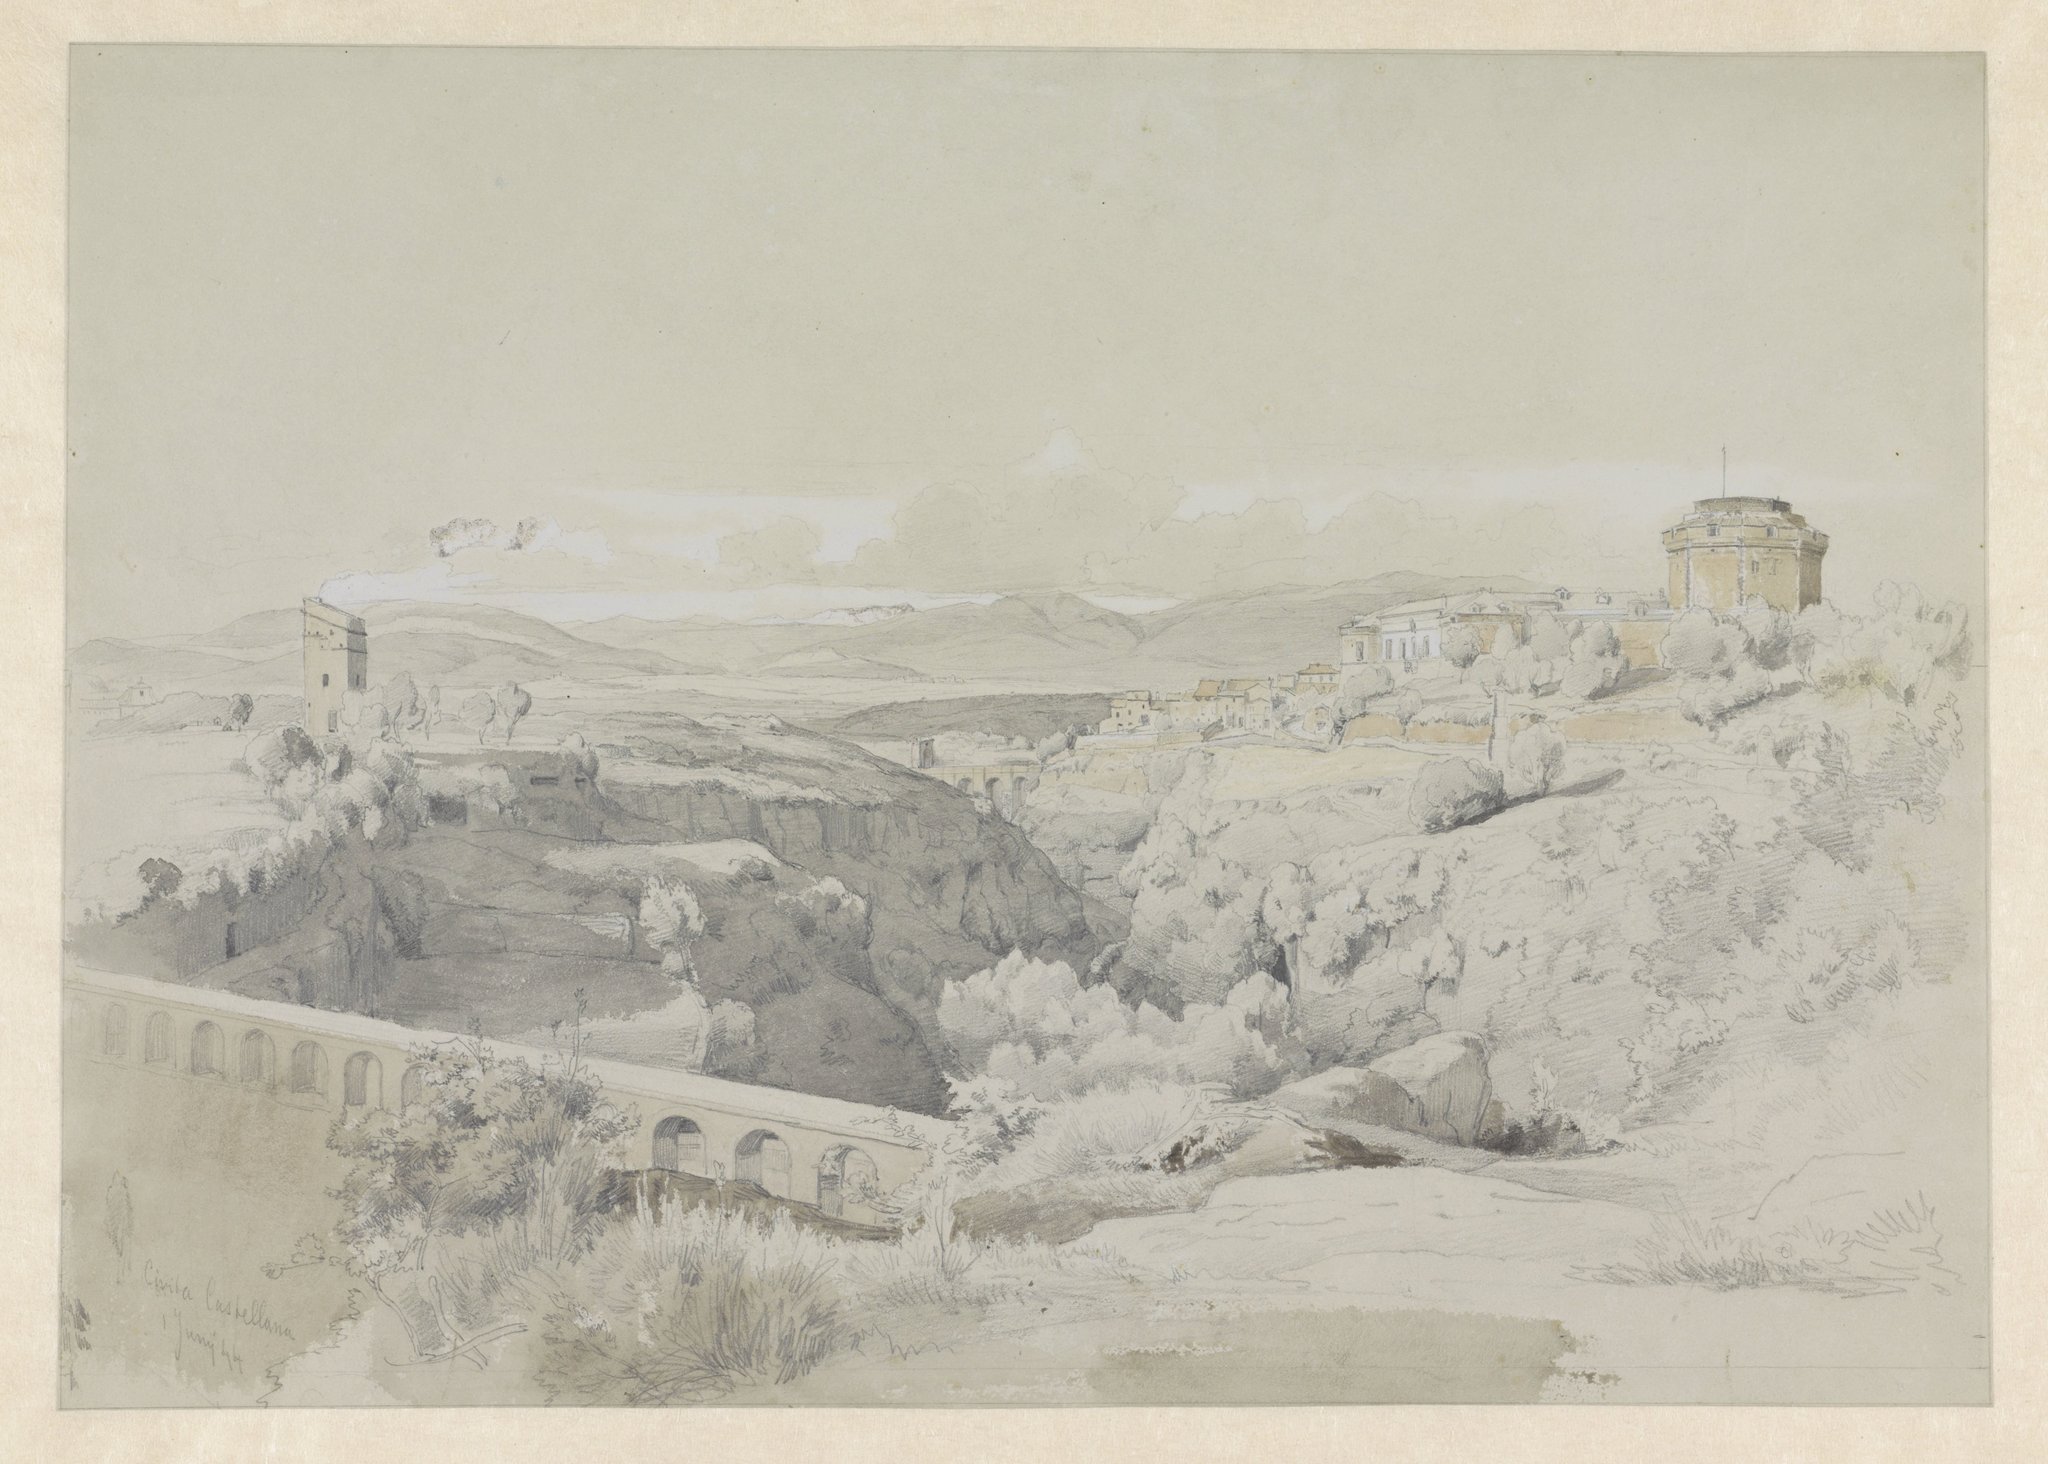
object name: drawing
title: Gezicht op Civita Castellana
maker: pierre louis dubourcq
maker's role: draughtsman, painter, print maker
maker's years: 1815-1873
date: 1844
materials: paper, pencil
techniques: brush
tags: low hill country